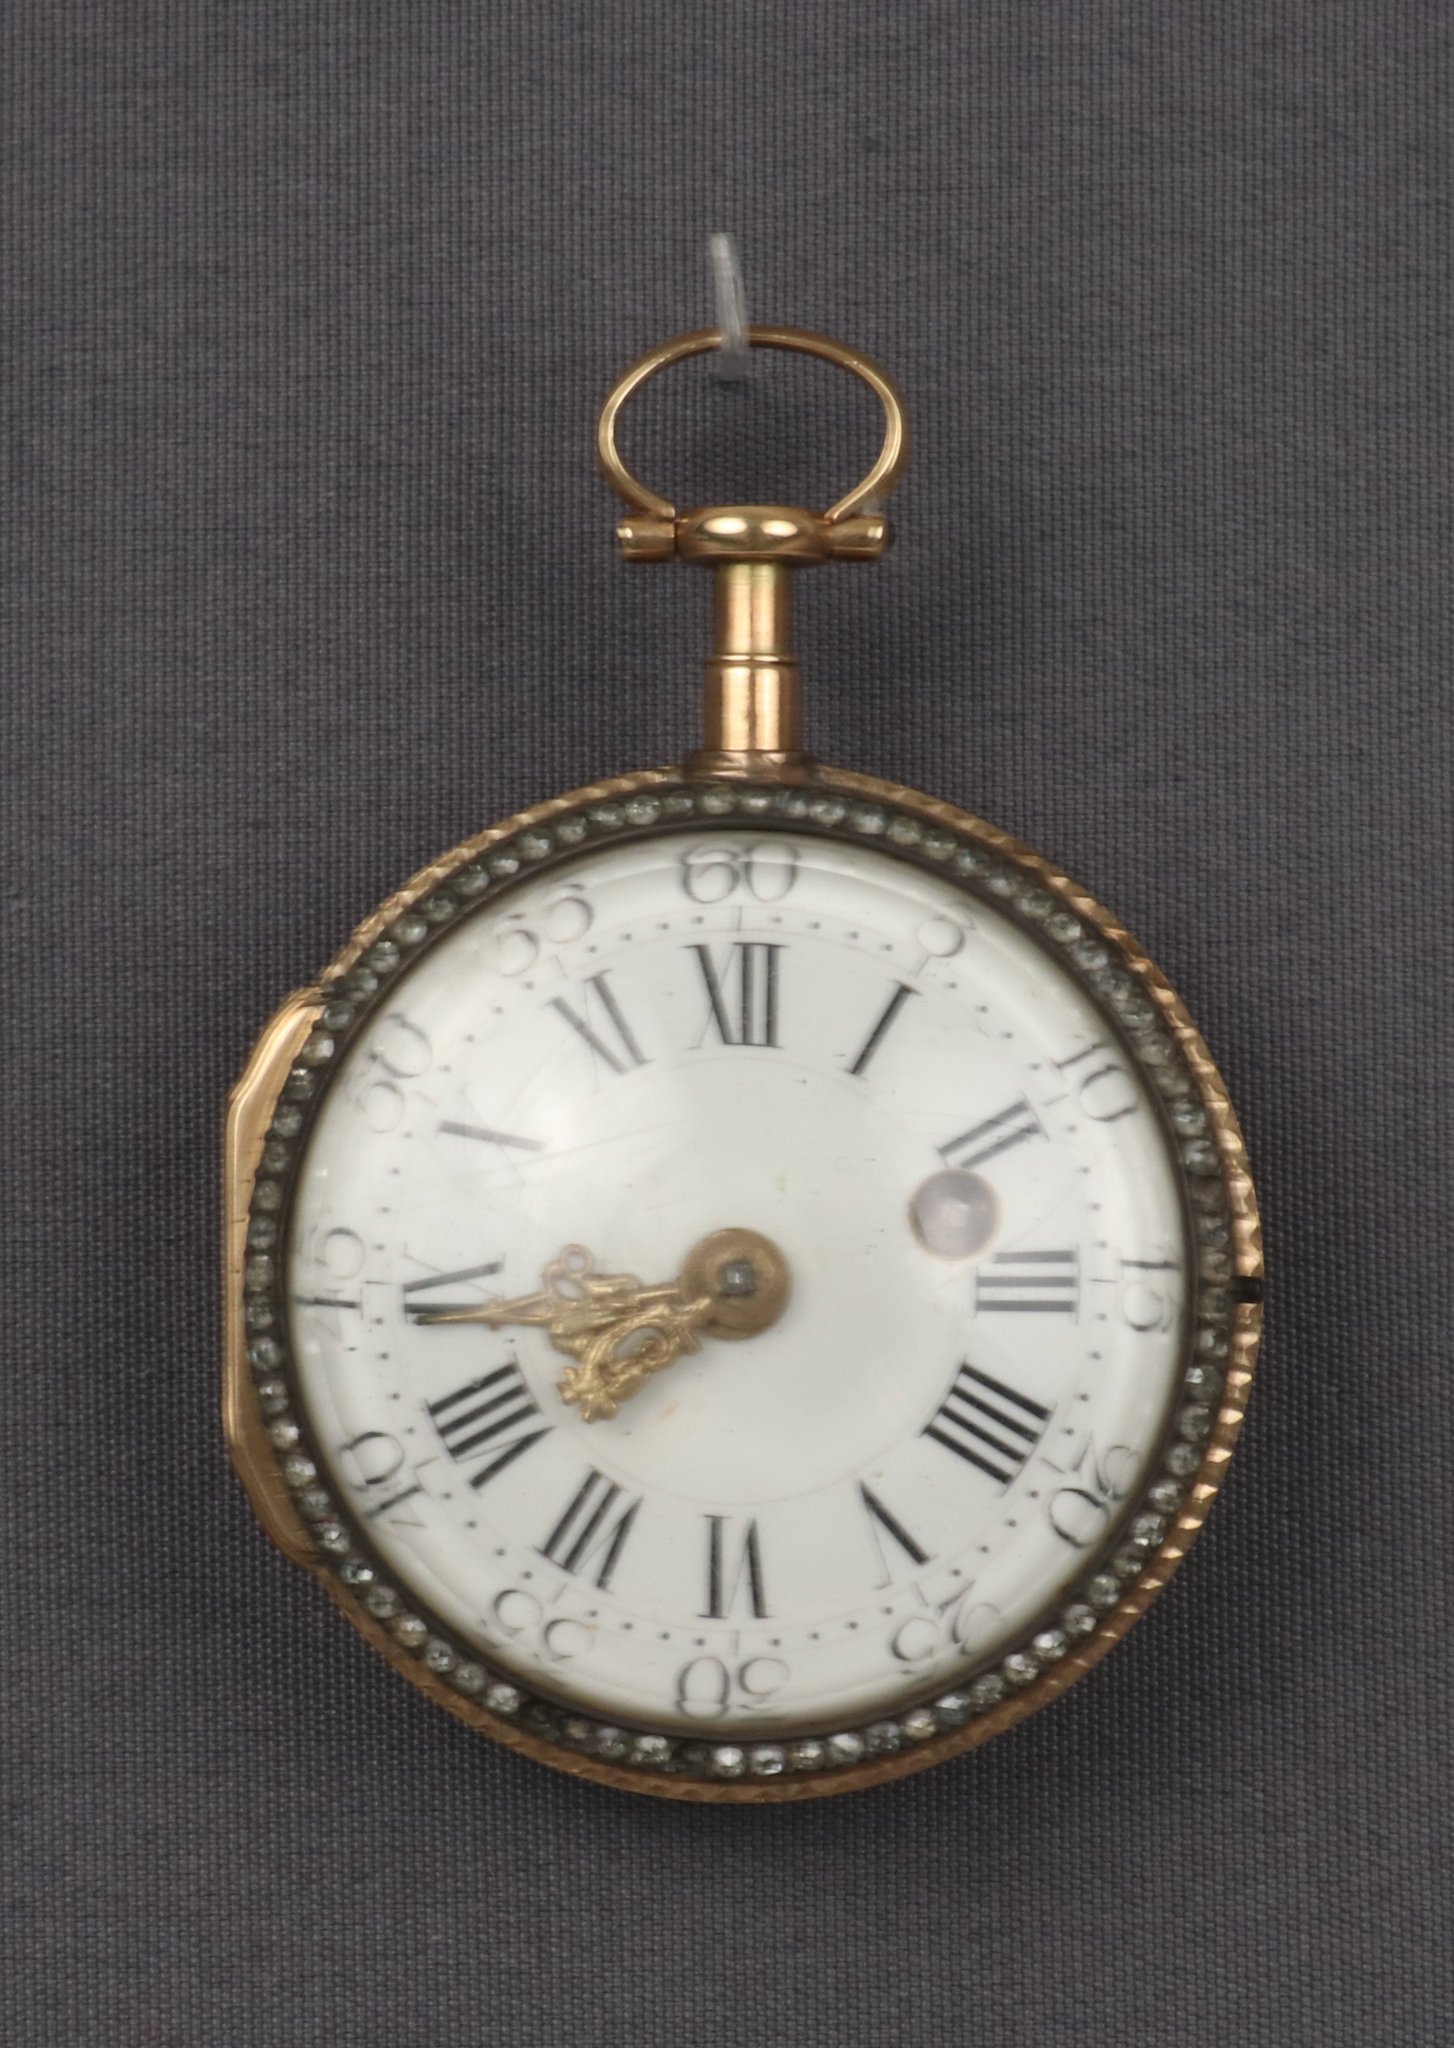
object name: watch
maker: jean romilly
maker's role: maker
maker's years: 1714-1794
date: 1780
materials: enamel, gold